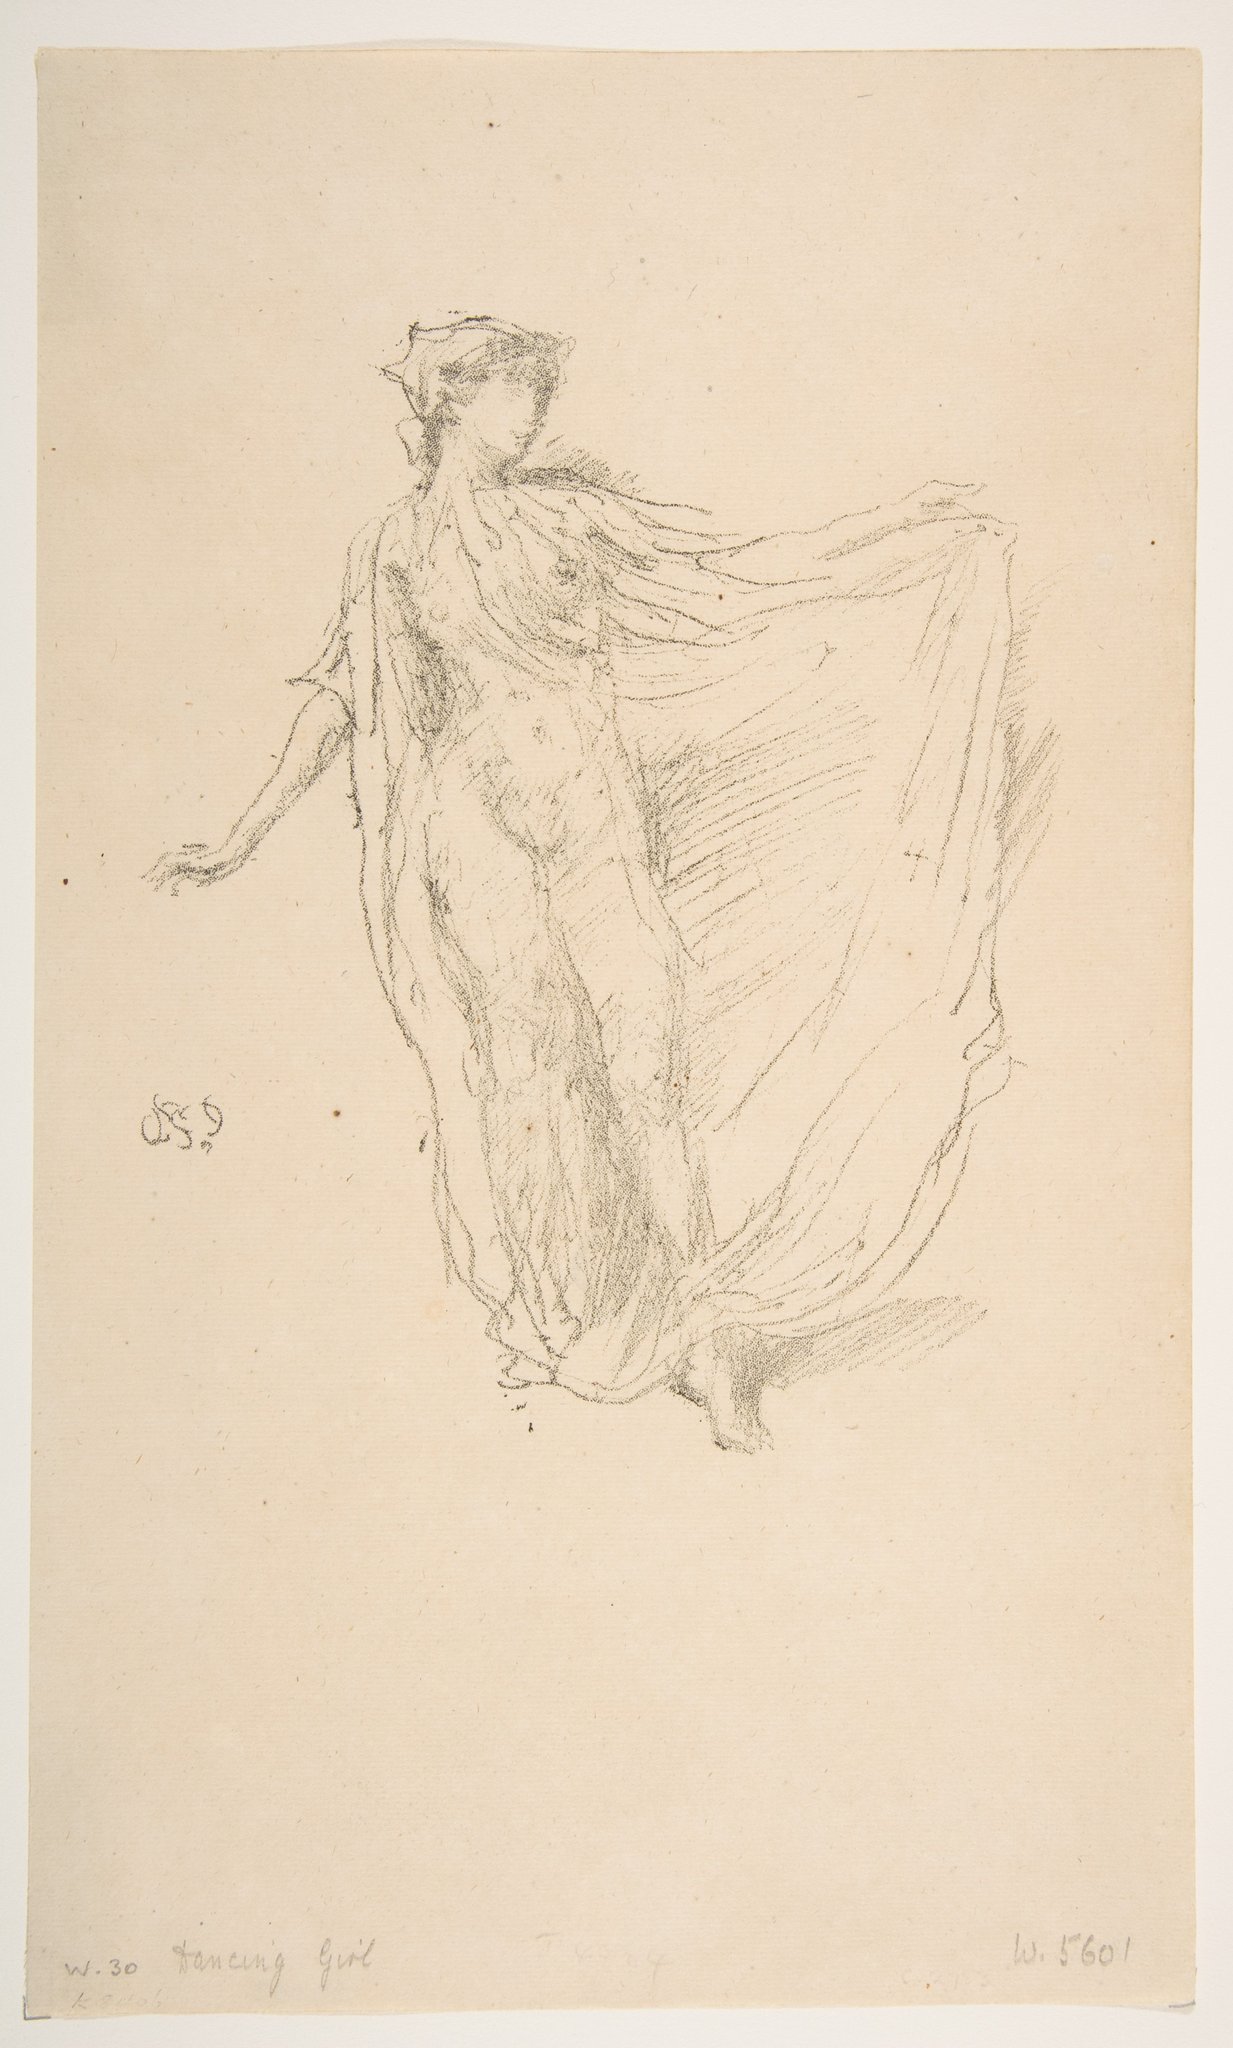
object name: print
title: Dancing Girl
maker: james mcneill whistler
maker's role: artist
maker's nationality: american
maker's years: 1834-1903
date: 1890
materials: ink, paper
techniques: printing, lithography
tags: girls,dancing